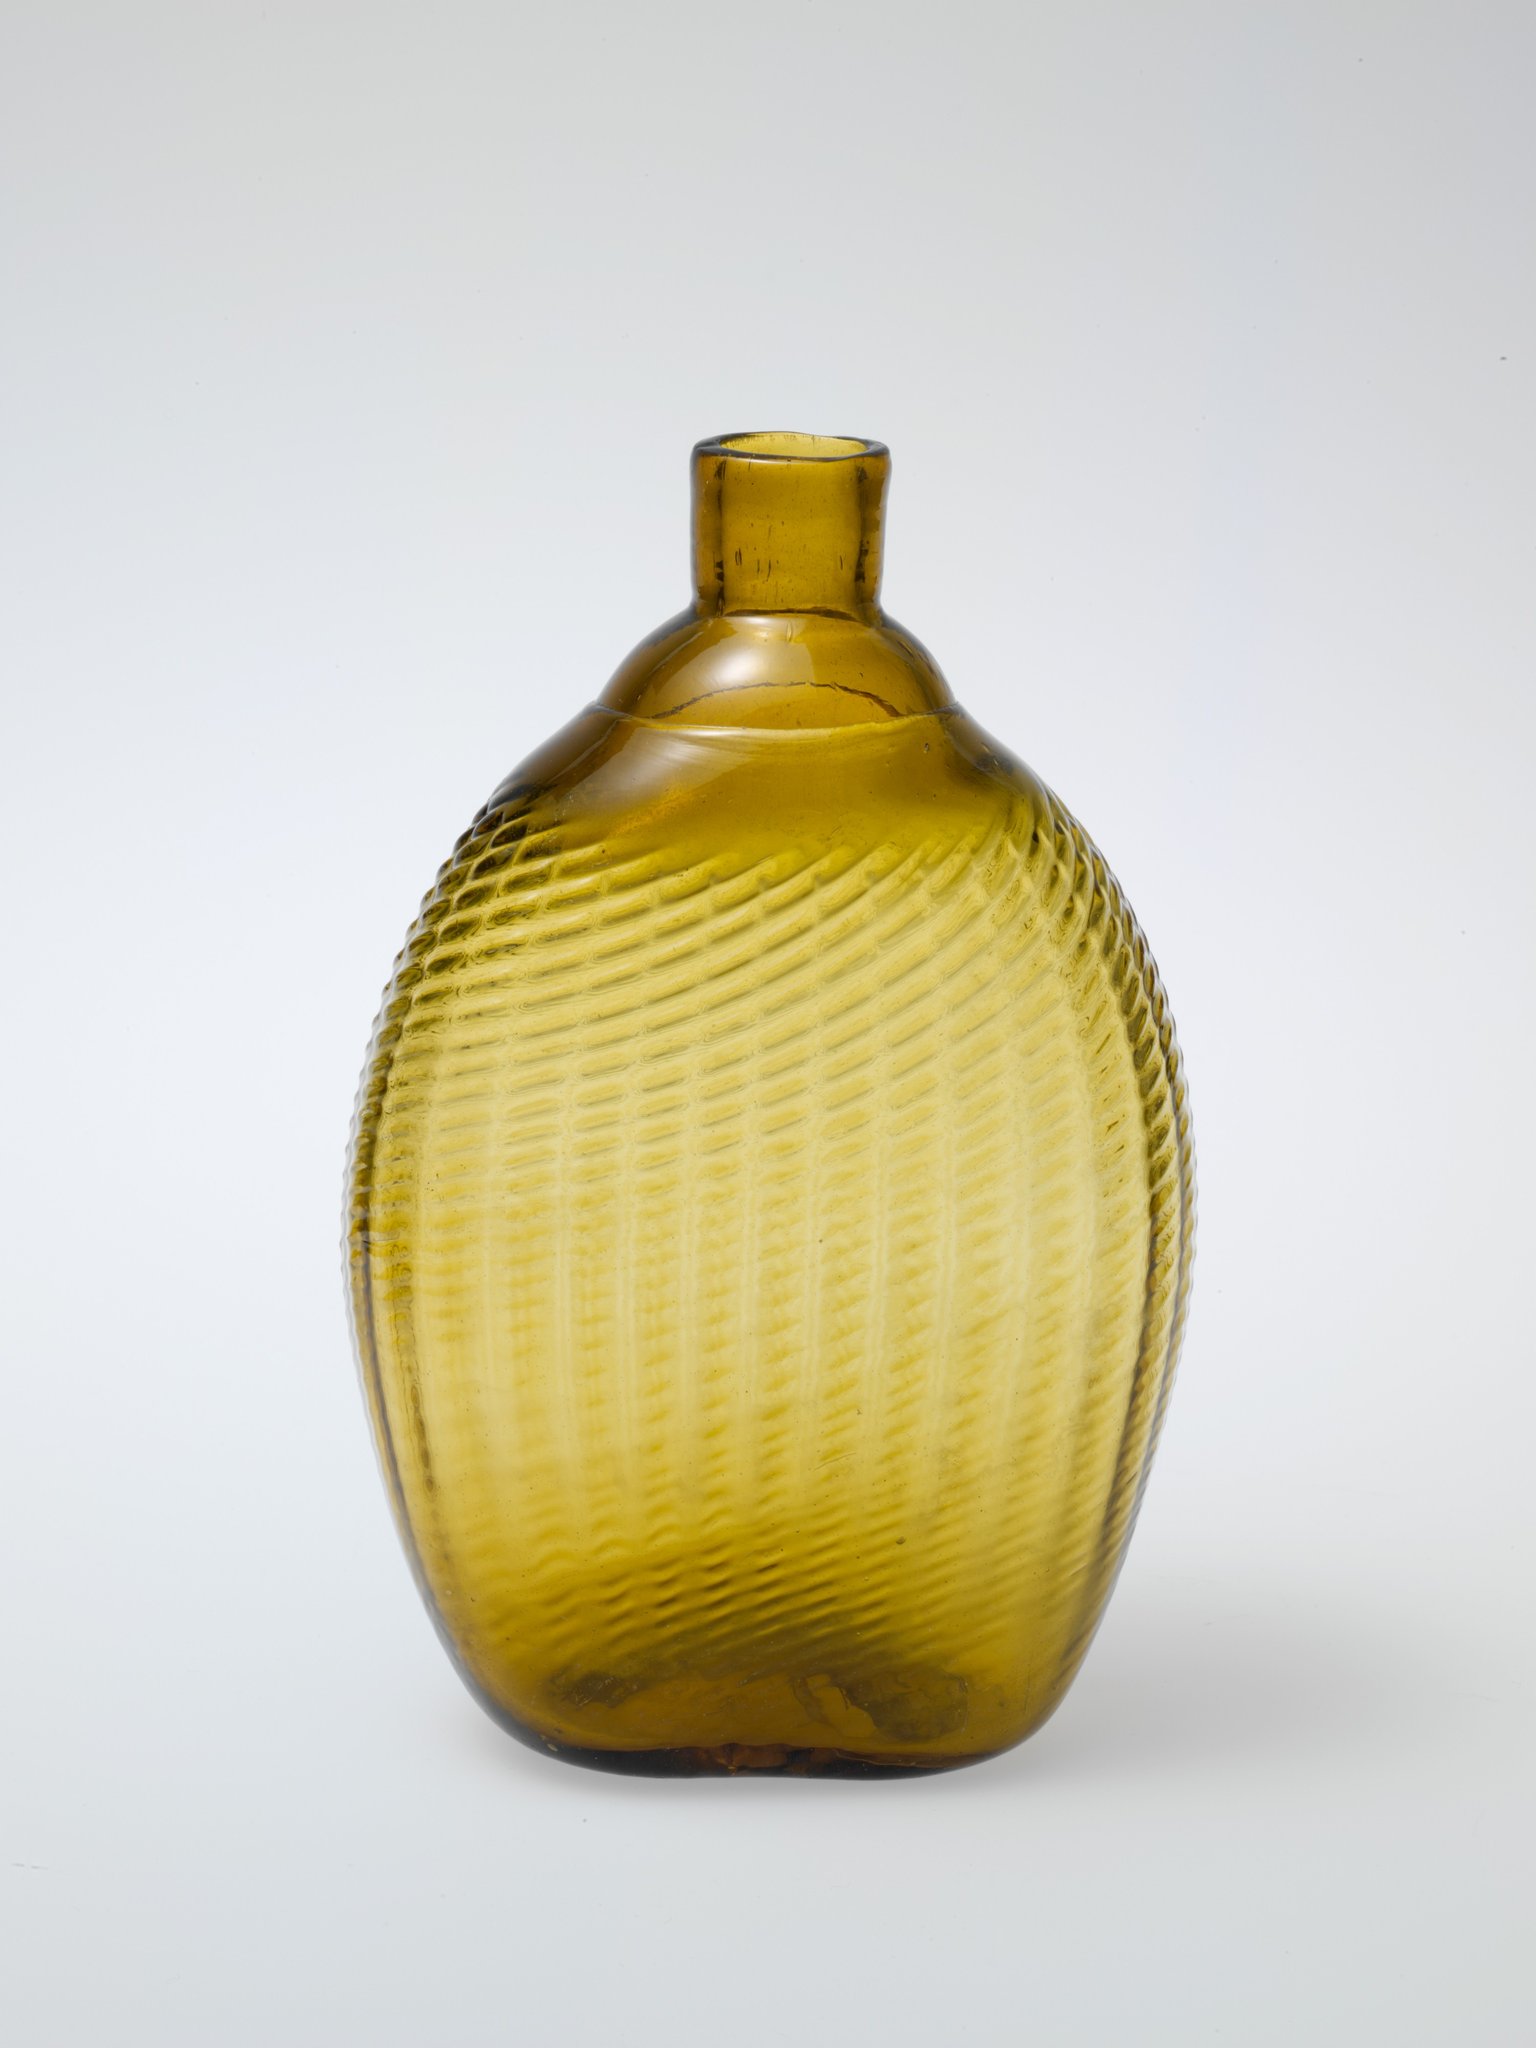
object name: pocket bottle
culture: american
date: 1815-1845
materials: glass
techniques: glassblowing, molding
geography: united states